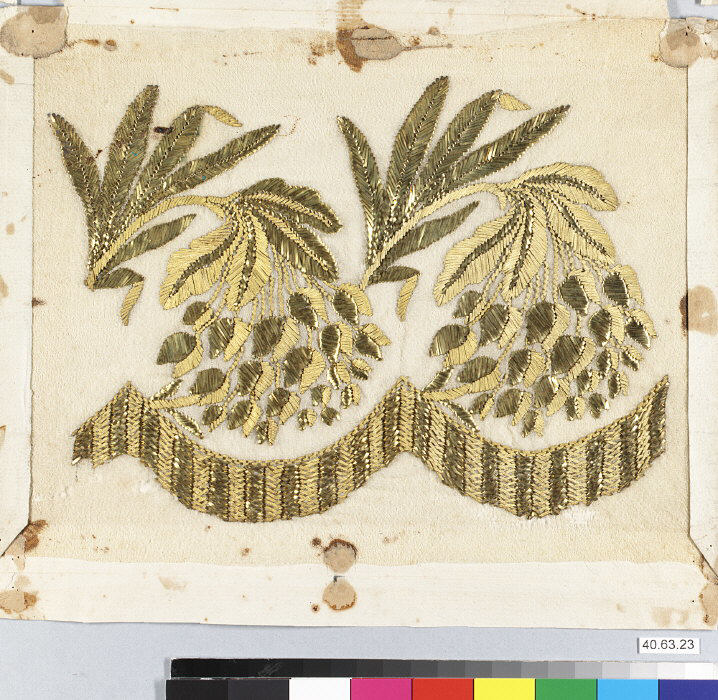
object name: border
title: Dress border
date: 1801-1833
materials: silk